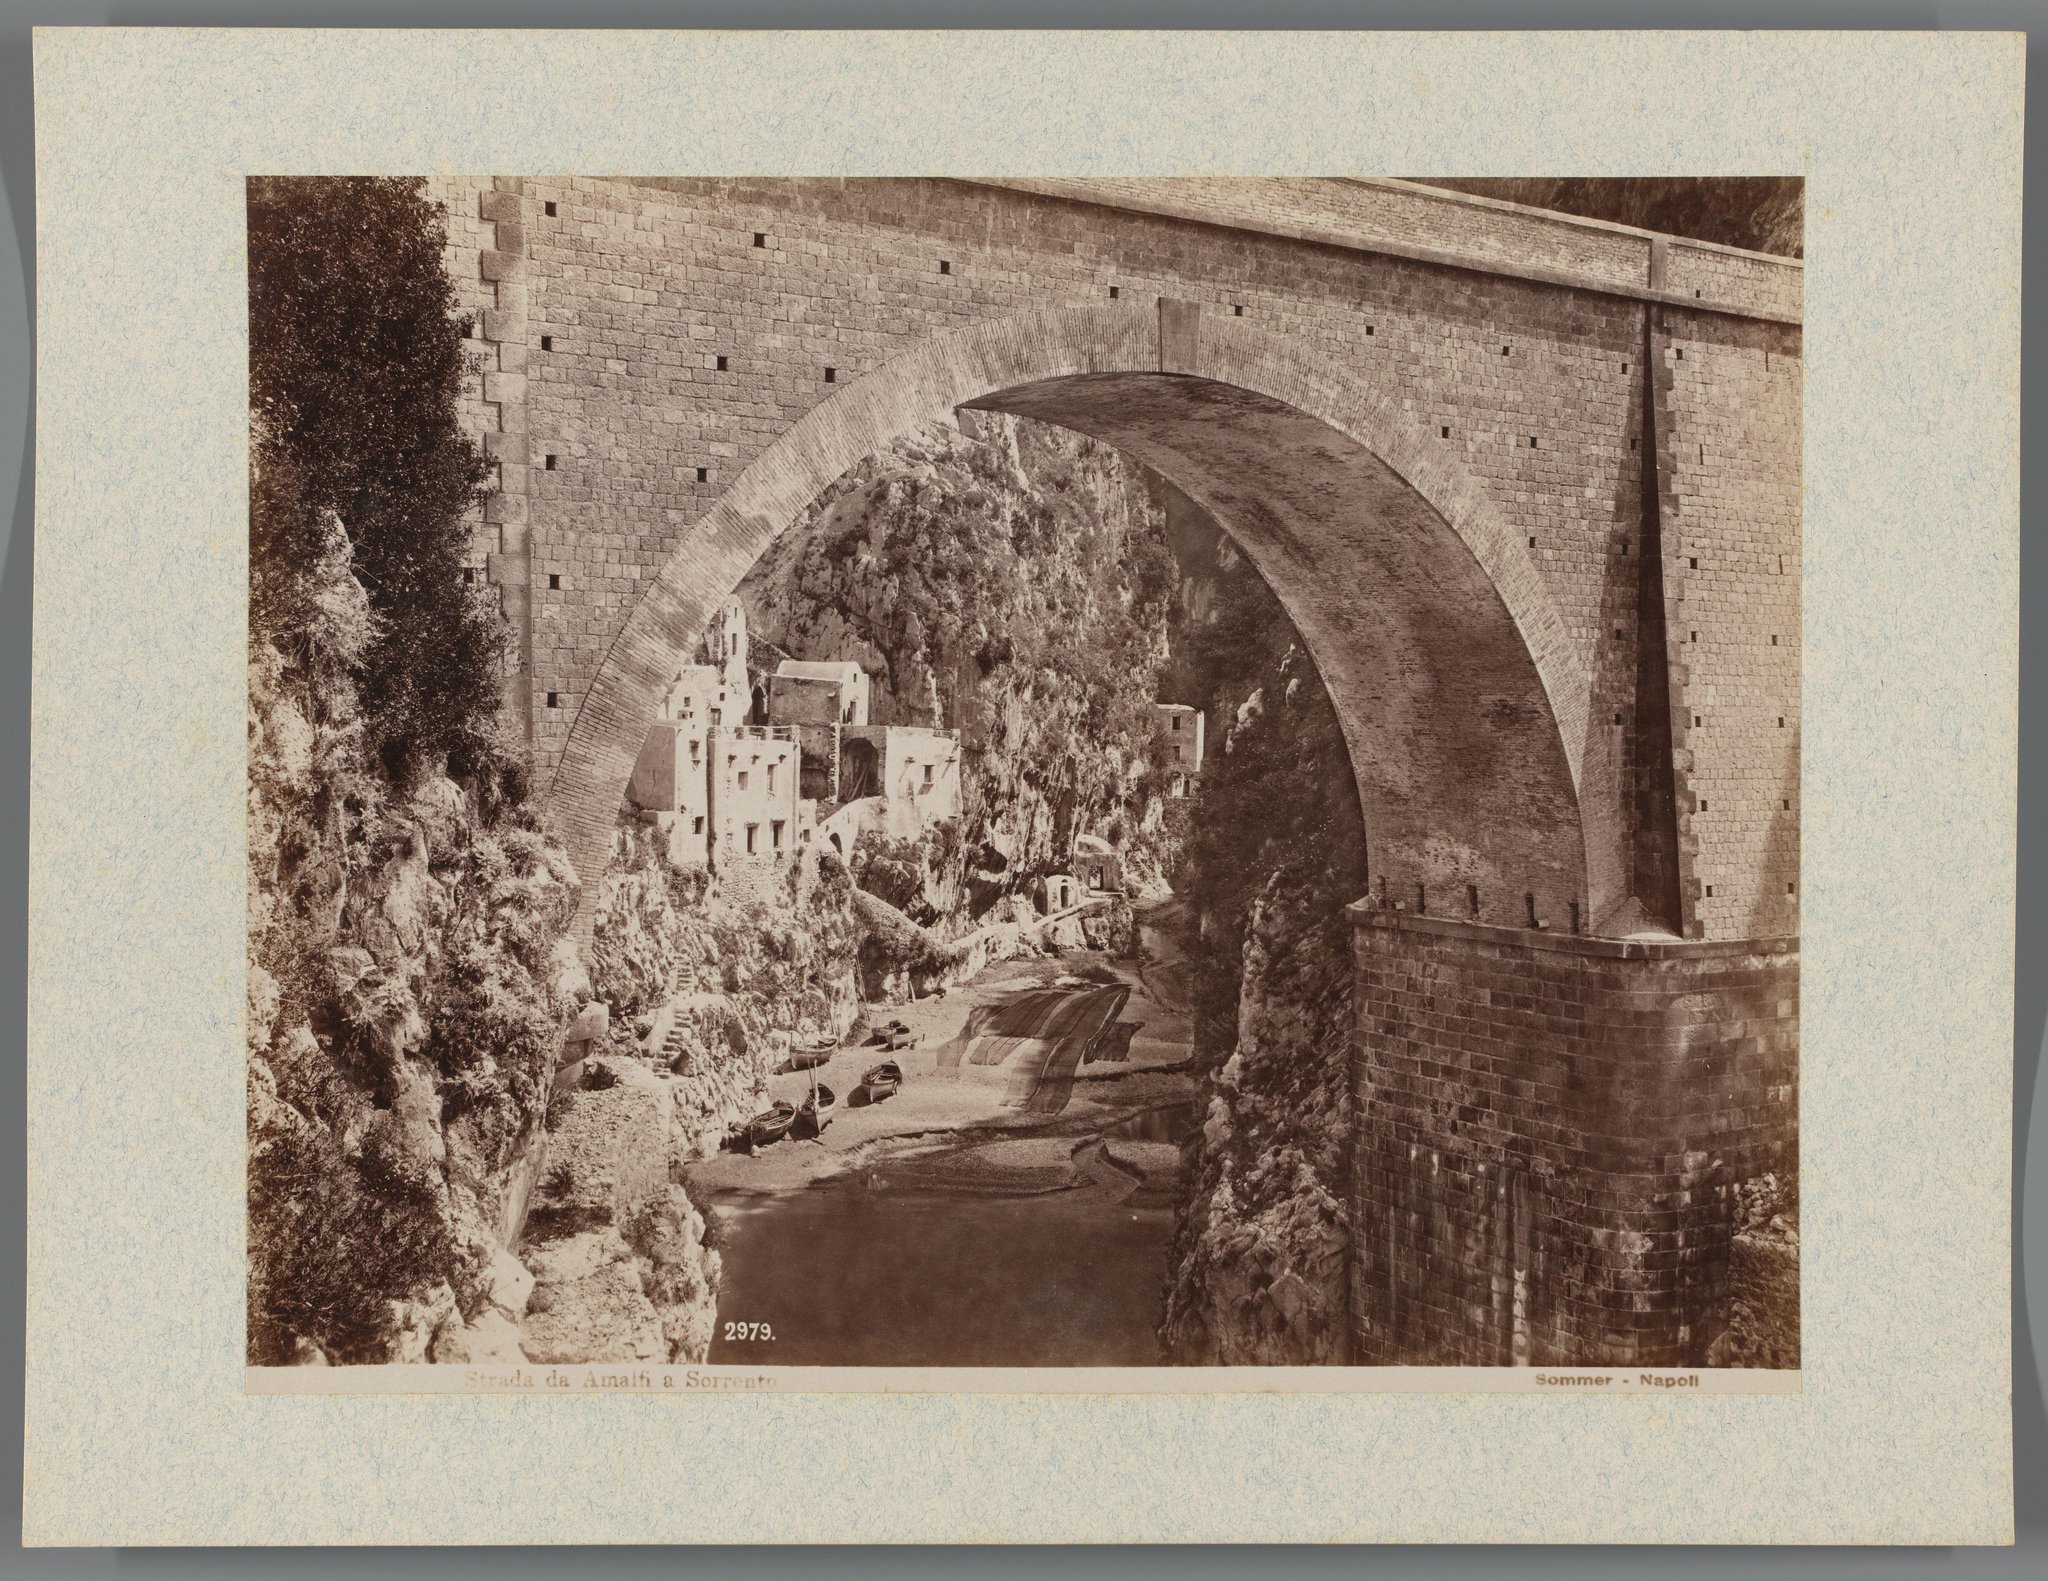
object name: photograph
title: Italië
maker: Anonymous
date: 1880-1910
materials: photographic support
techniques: albumen print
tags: italy